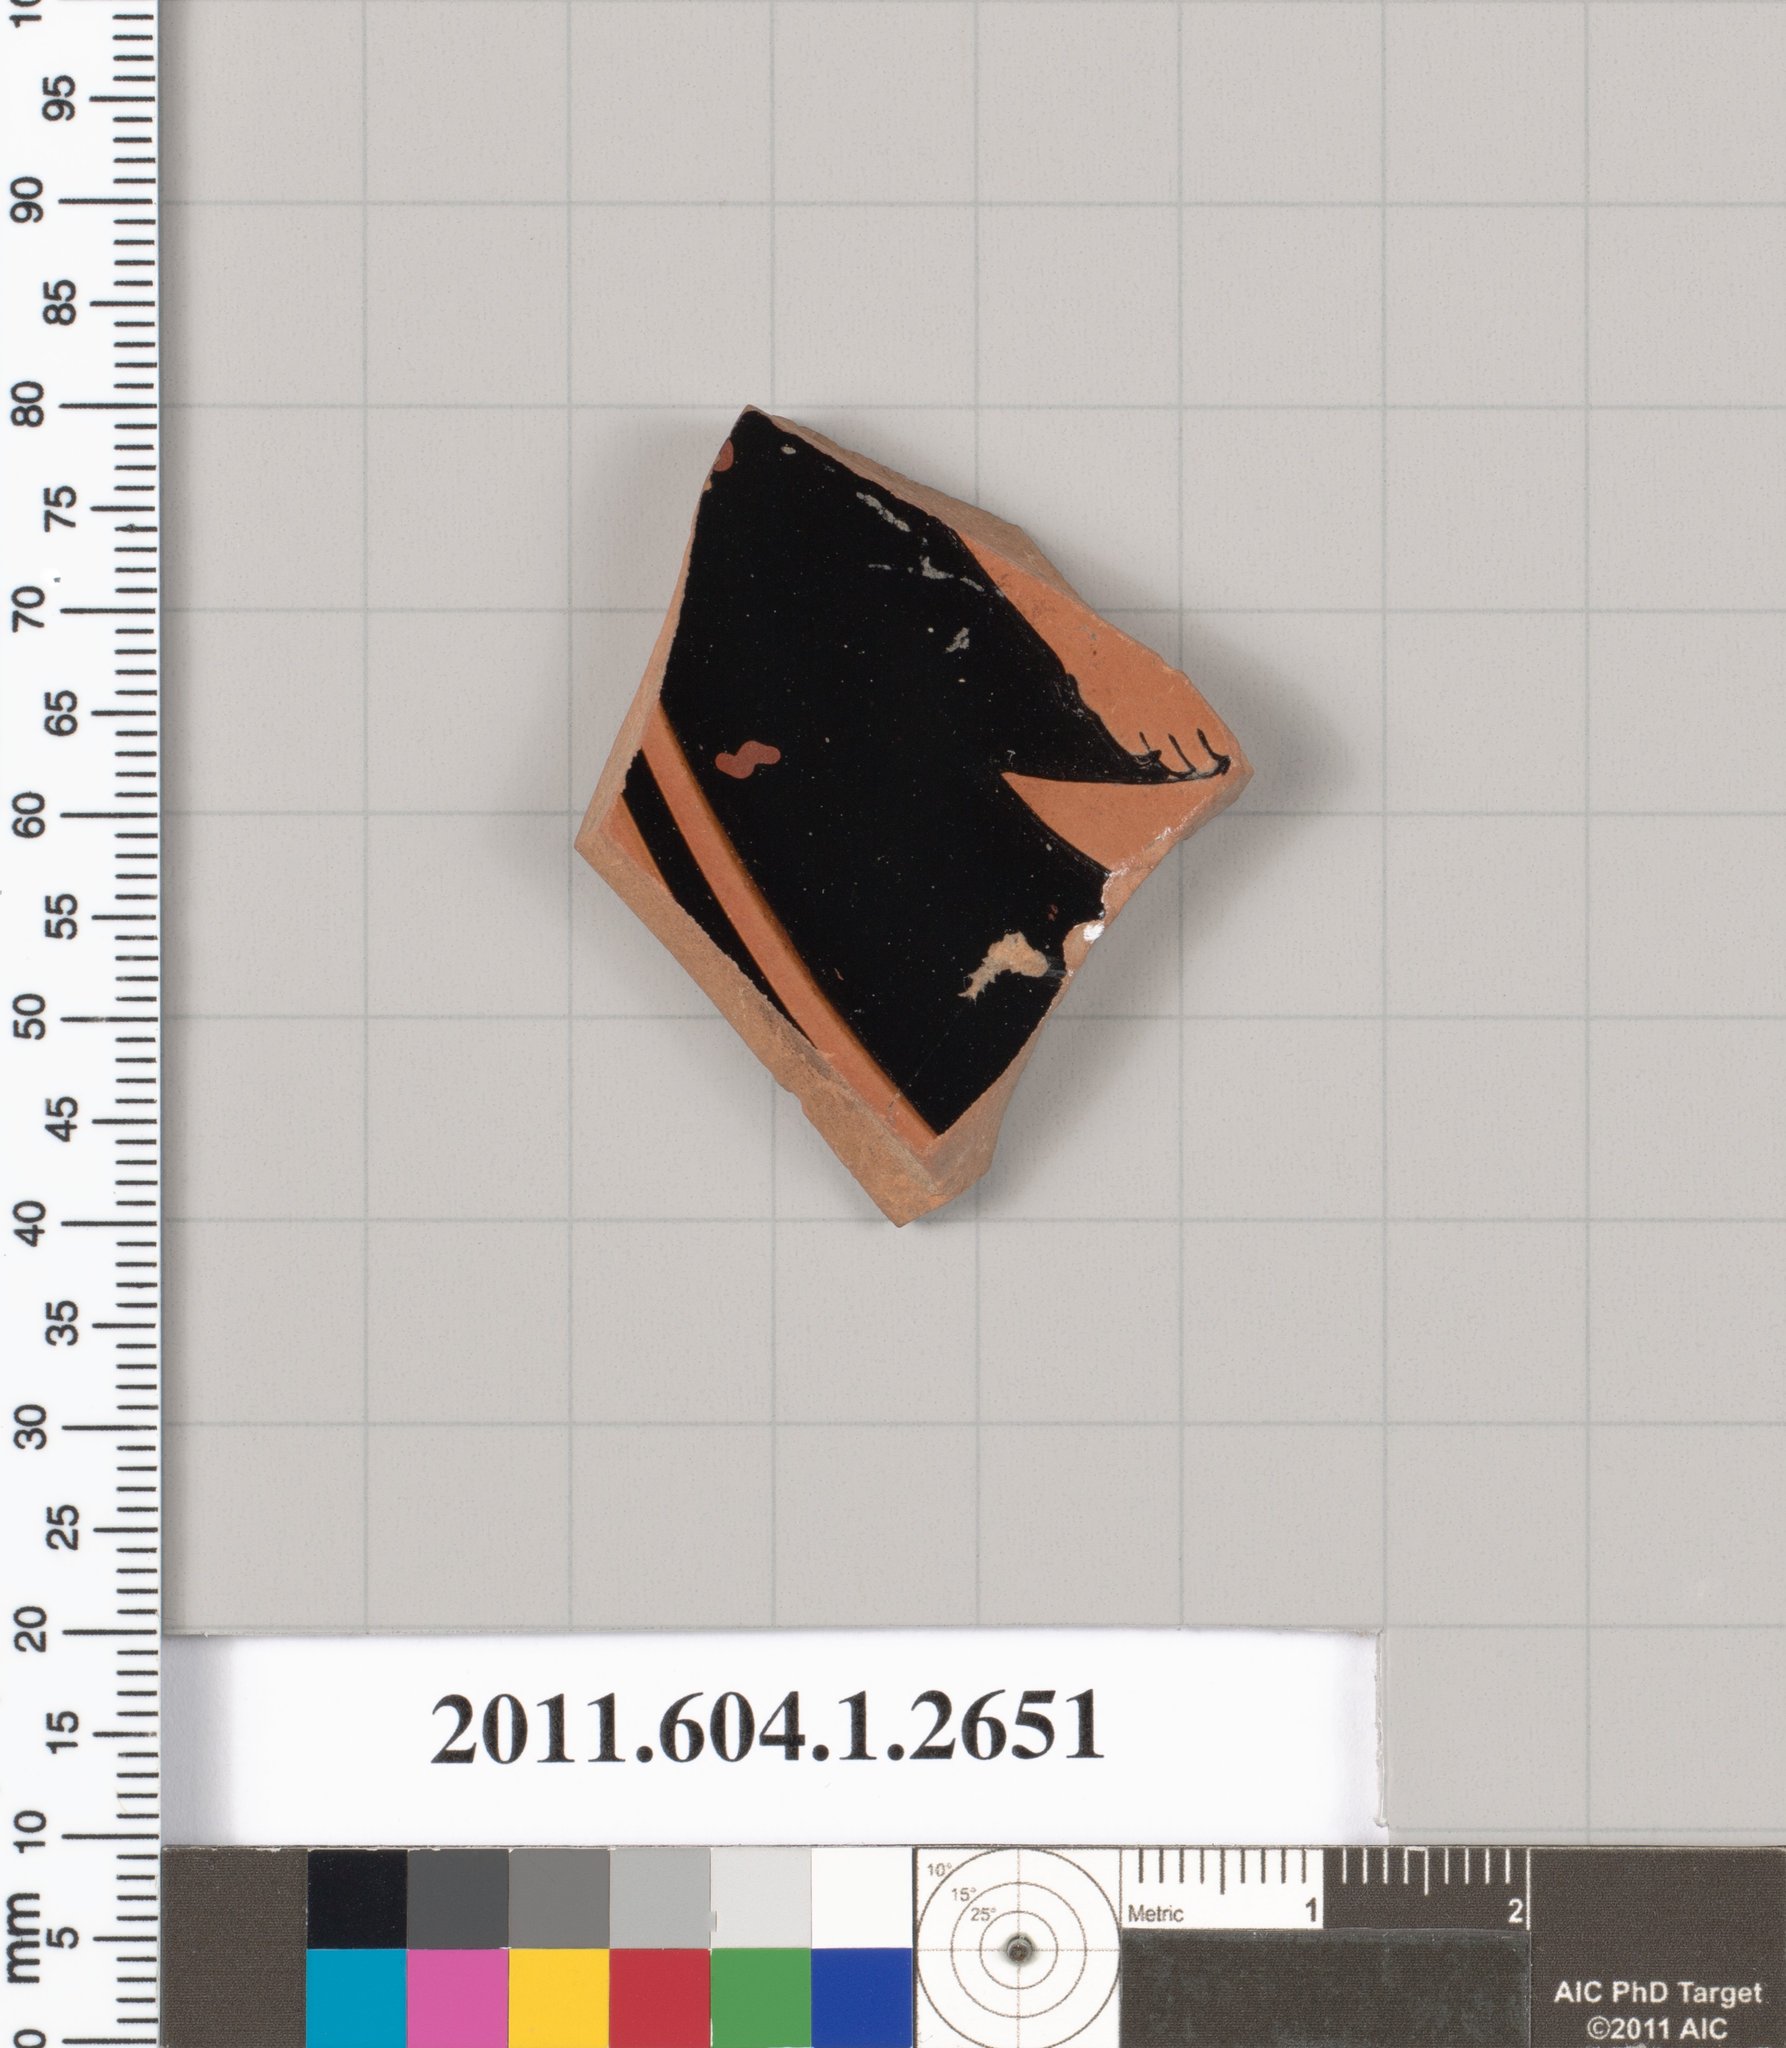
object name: kylix fragment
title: Terracotta fragment of a kylix (drinking cup)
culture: greek, attic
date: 520-500 BCE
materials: terracotta